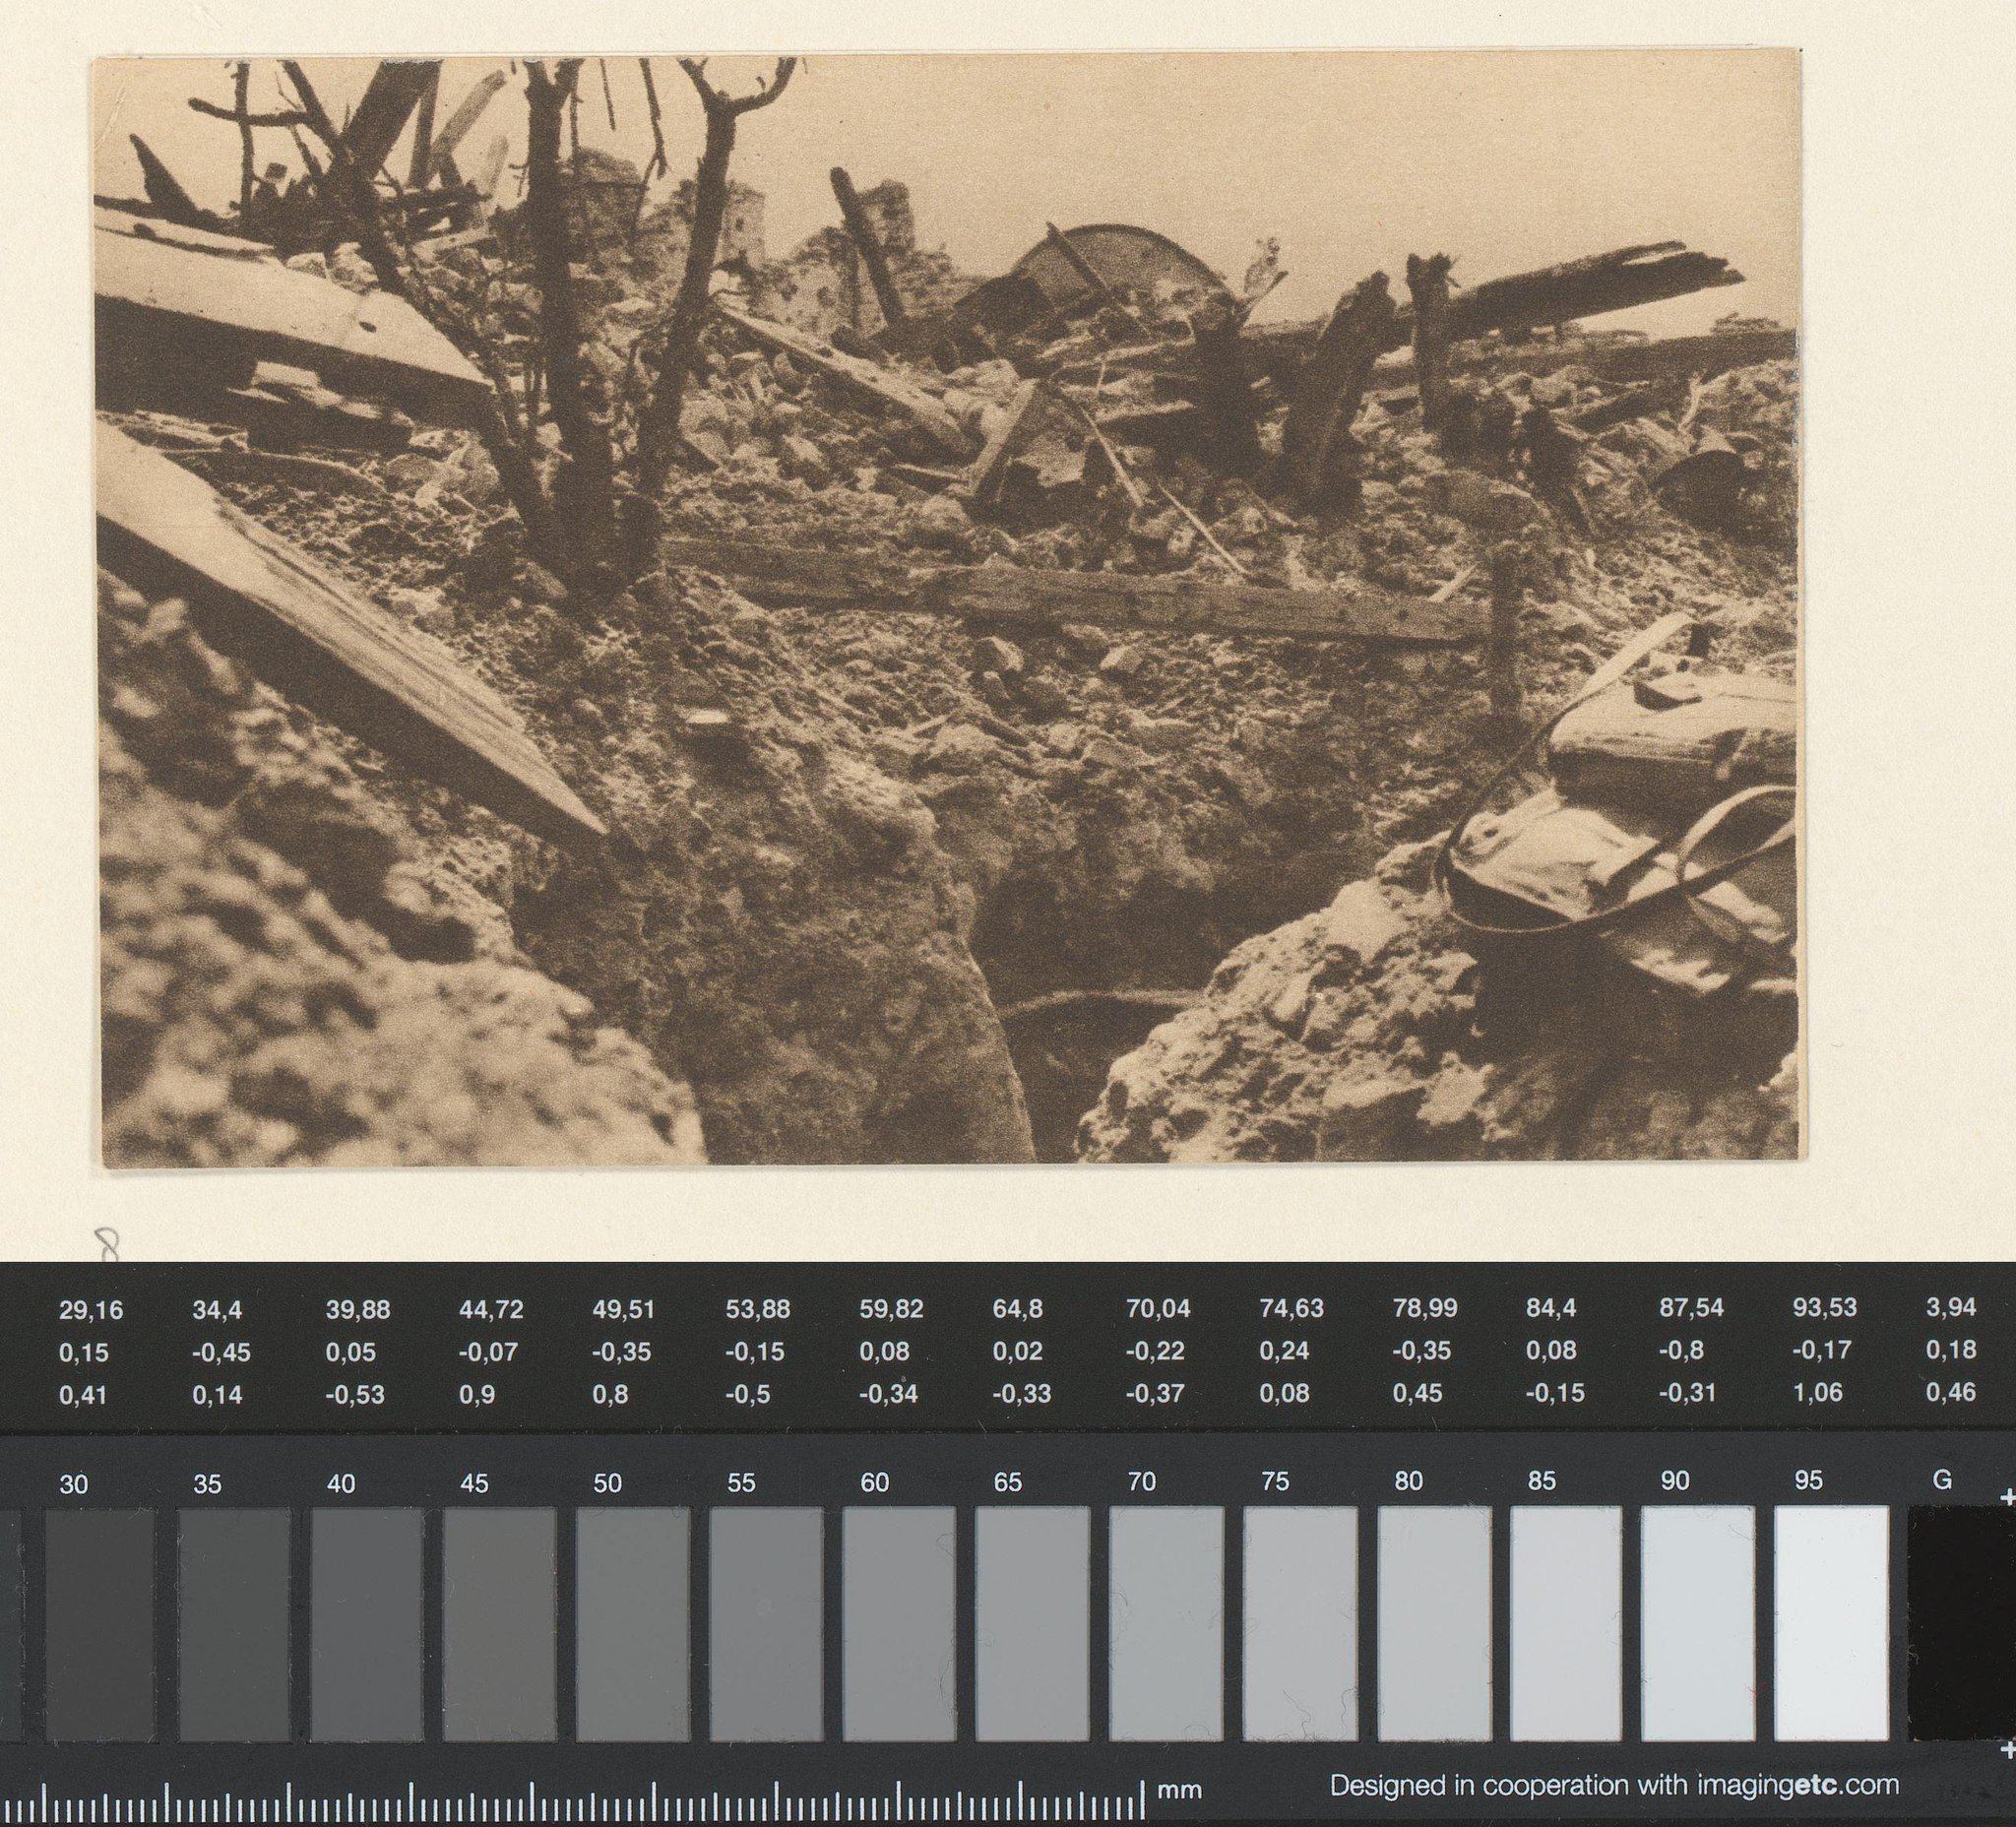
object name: ansichtkaart, prentbriefkaart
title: 12 cartes postales illustrées de la Grande Guerre / Pochette No 2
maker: sémaphore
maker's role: printer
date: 1915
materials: paper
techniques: photograph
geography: marseille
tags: trenches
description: Resten van een Duitse loopgraaf. Onderdeel van de tweede serie van twaalf (acht aanwezig) prentbriefkaarten over de Eerste Wereldoorlog, 1915.